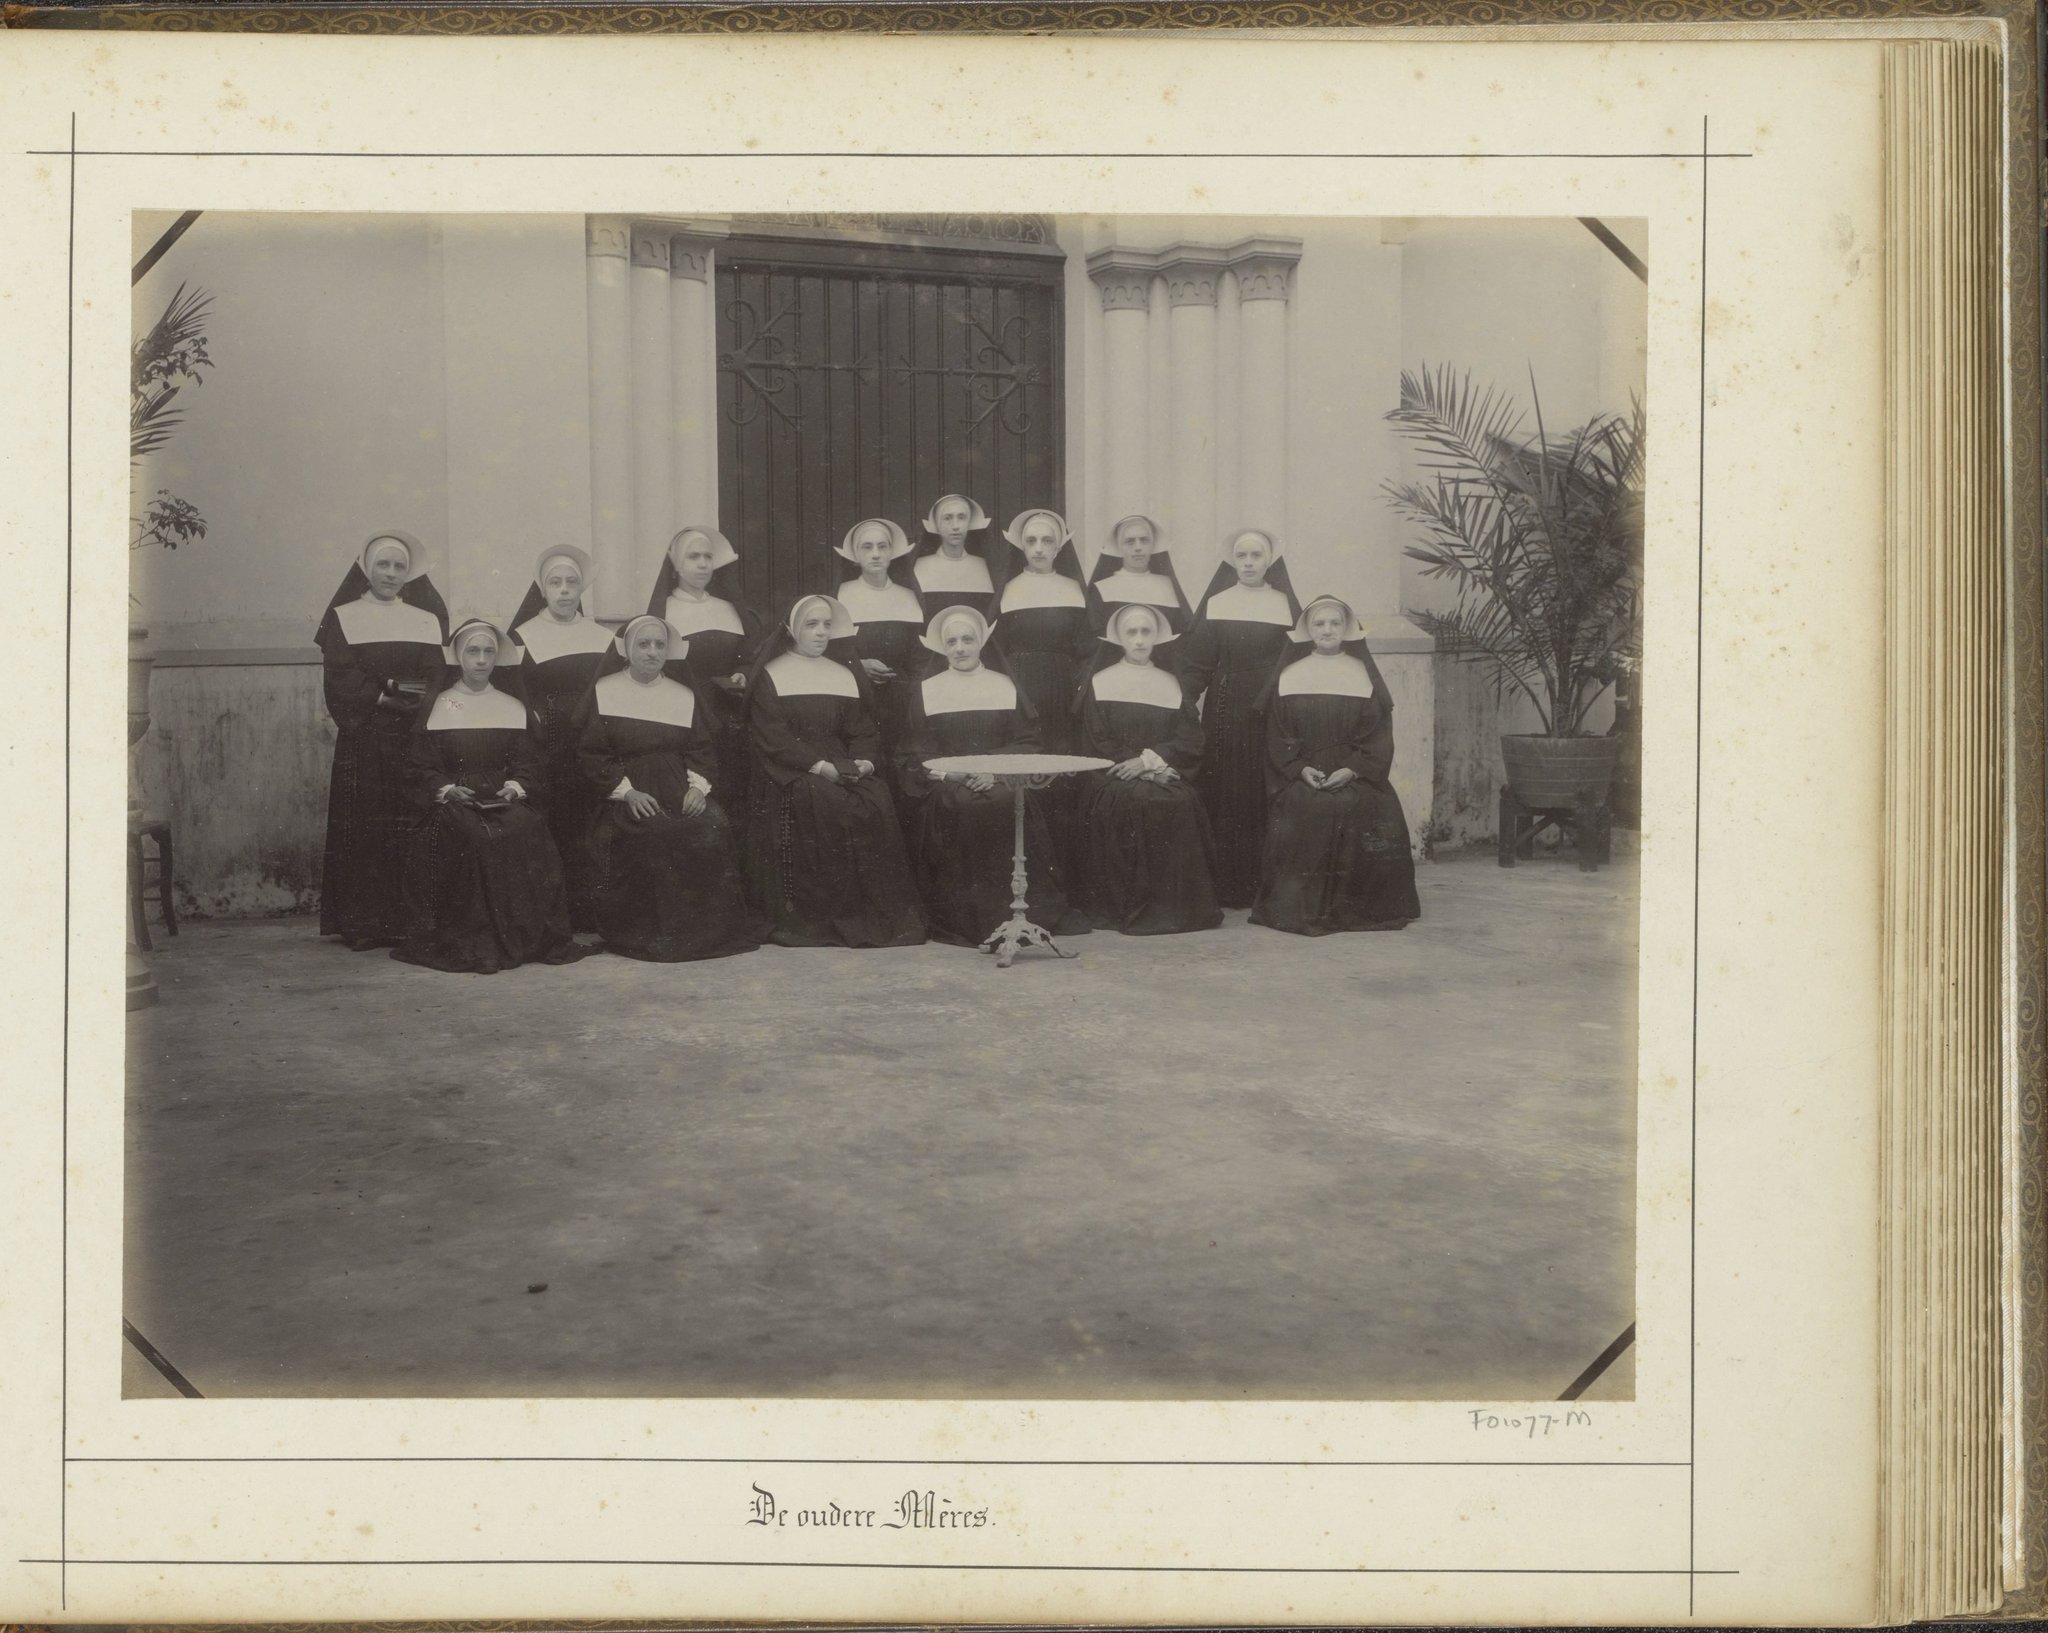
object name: photograph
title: Groepsportret van oudere zusters Ursulinen, vermoedelijk in Weltevreden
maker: Anonymous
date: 1890-1910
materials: paper, photographic support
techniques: albumen print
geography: weltevreden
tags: nun(s)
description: Onderdeel van Album met foto's van Batavia en van de zusters Ursulinen.